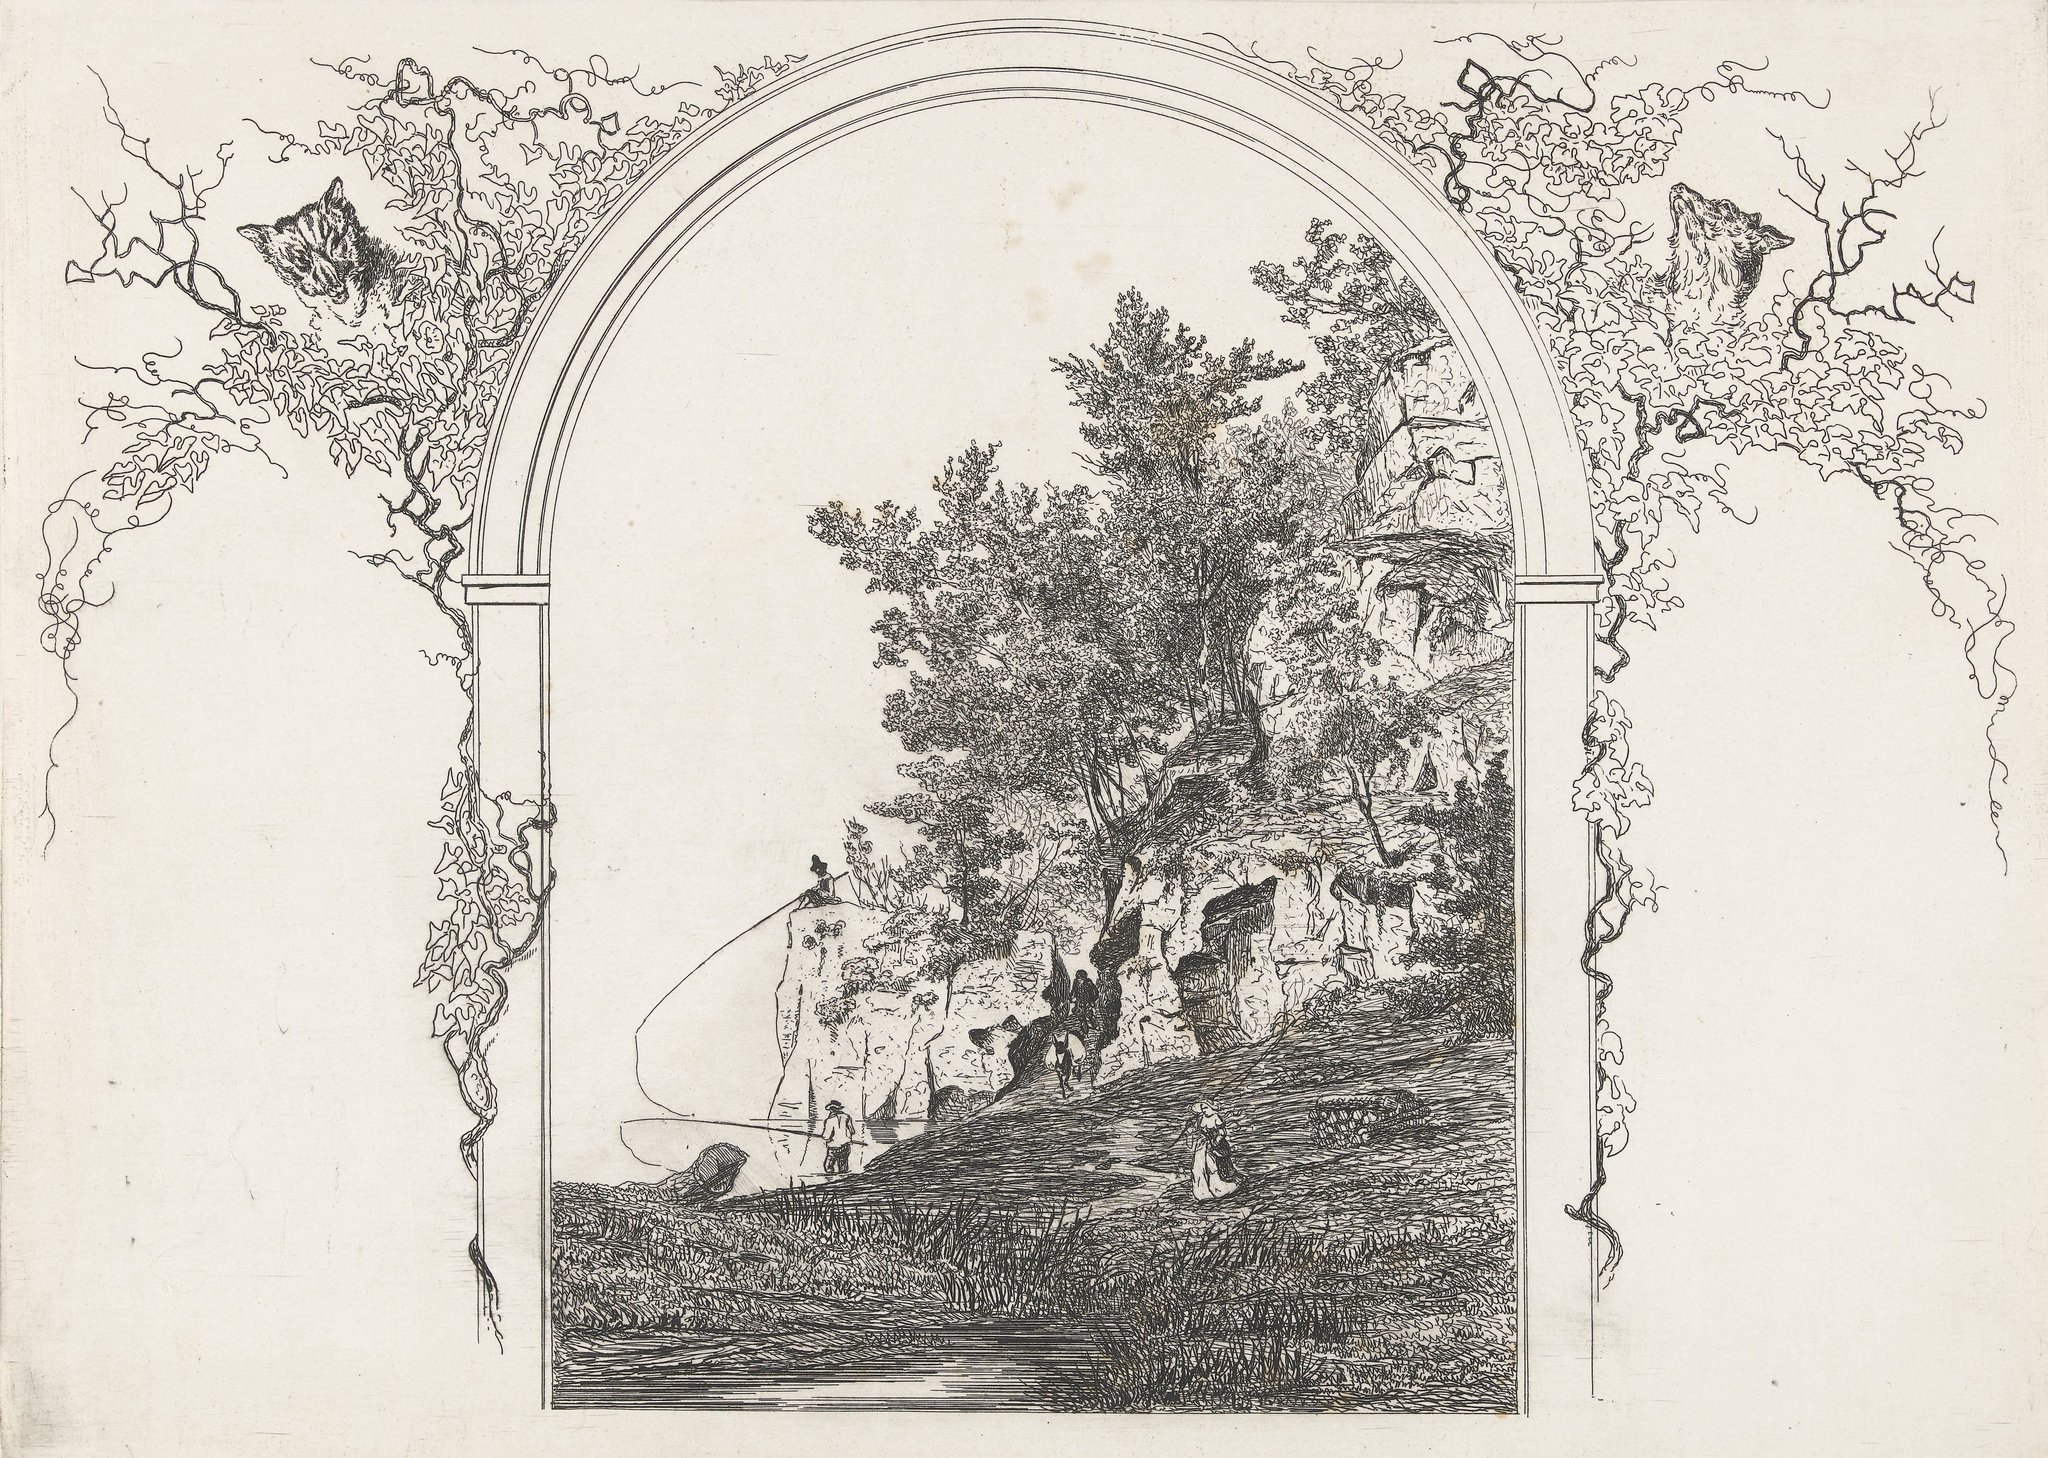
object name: print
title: Rots met vissers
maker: martinus antonius kuytenbrouwer jr.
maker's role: draughtsman, painter, print maker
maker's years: 1821-1897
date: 1853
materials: paper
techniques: drypoint, etching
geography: brussels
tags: ass, donkey, river, rocks, fisherman, beasts of prey, predatory animals: fox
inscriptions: collector's mark: Lugt 2228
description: Vanaf een rots heeft een visser zijn hengel uitgegooid in het water, terwijl een tweede visser aan de waterkant staat te hengelen. Op een pad, dat door de rotsen voert, loopt een man met een ezel en rechts loopt een vrouw met een hengel over haar schouder. De voorstelling is omlijst door een met begroeiing en twee vossen versierd venster.